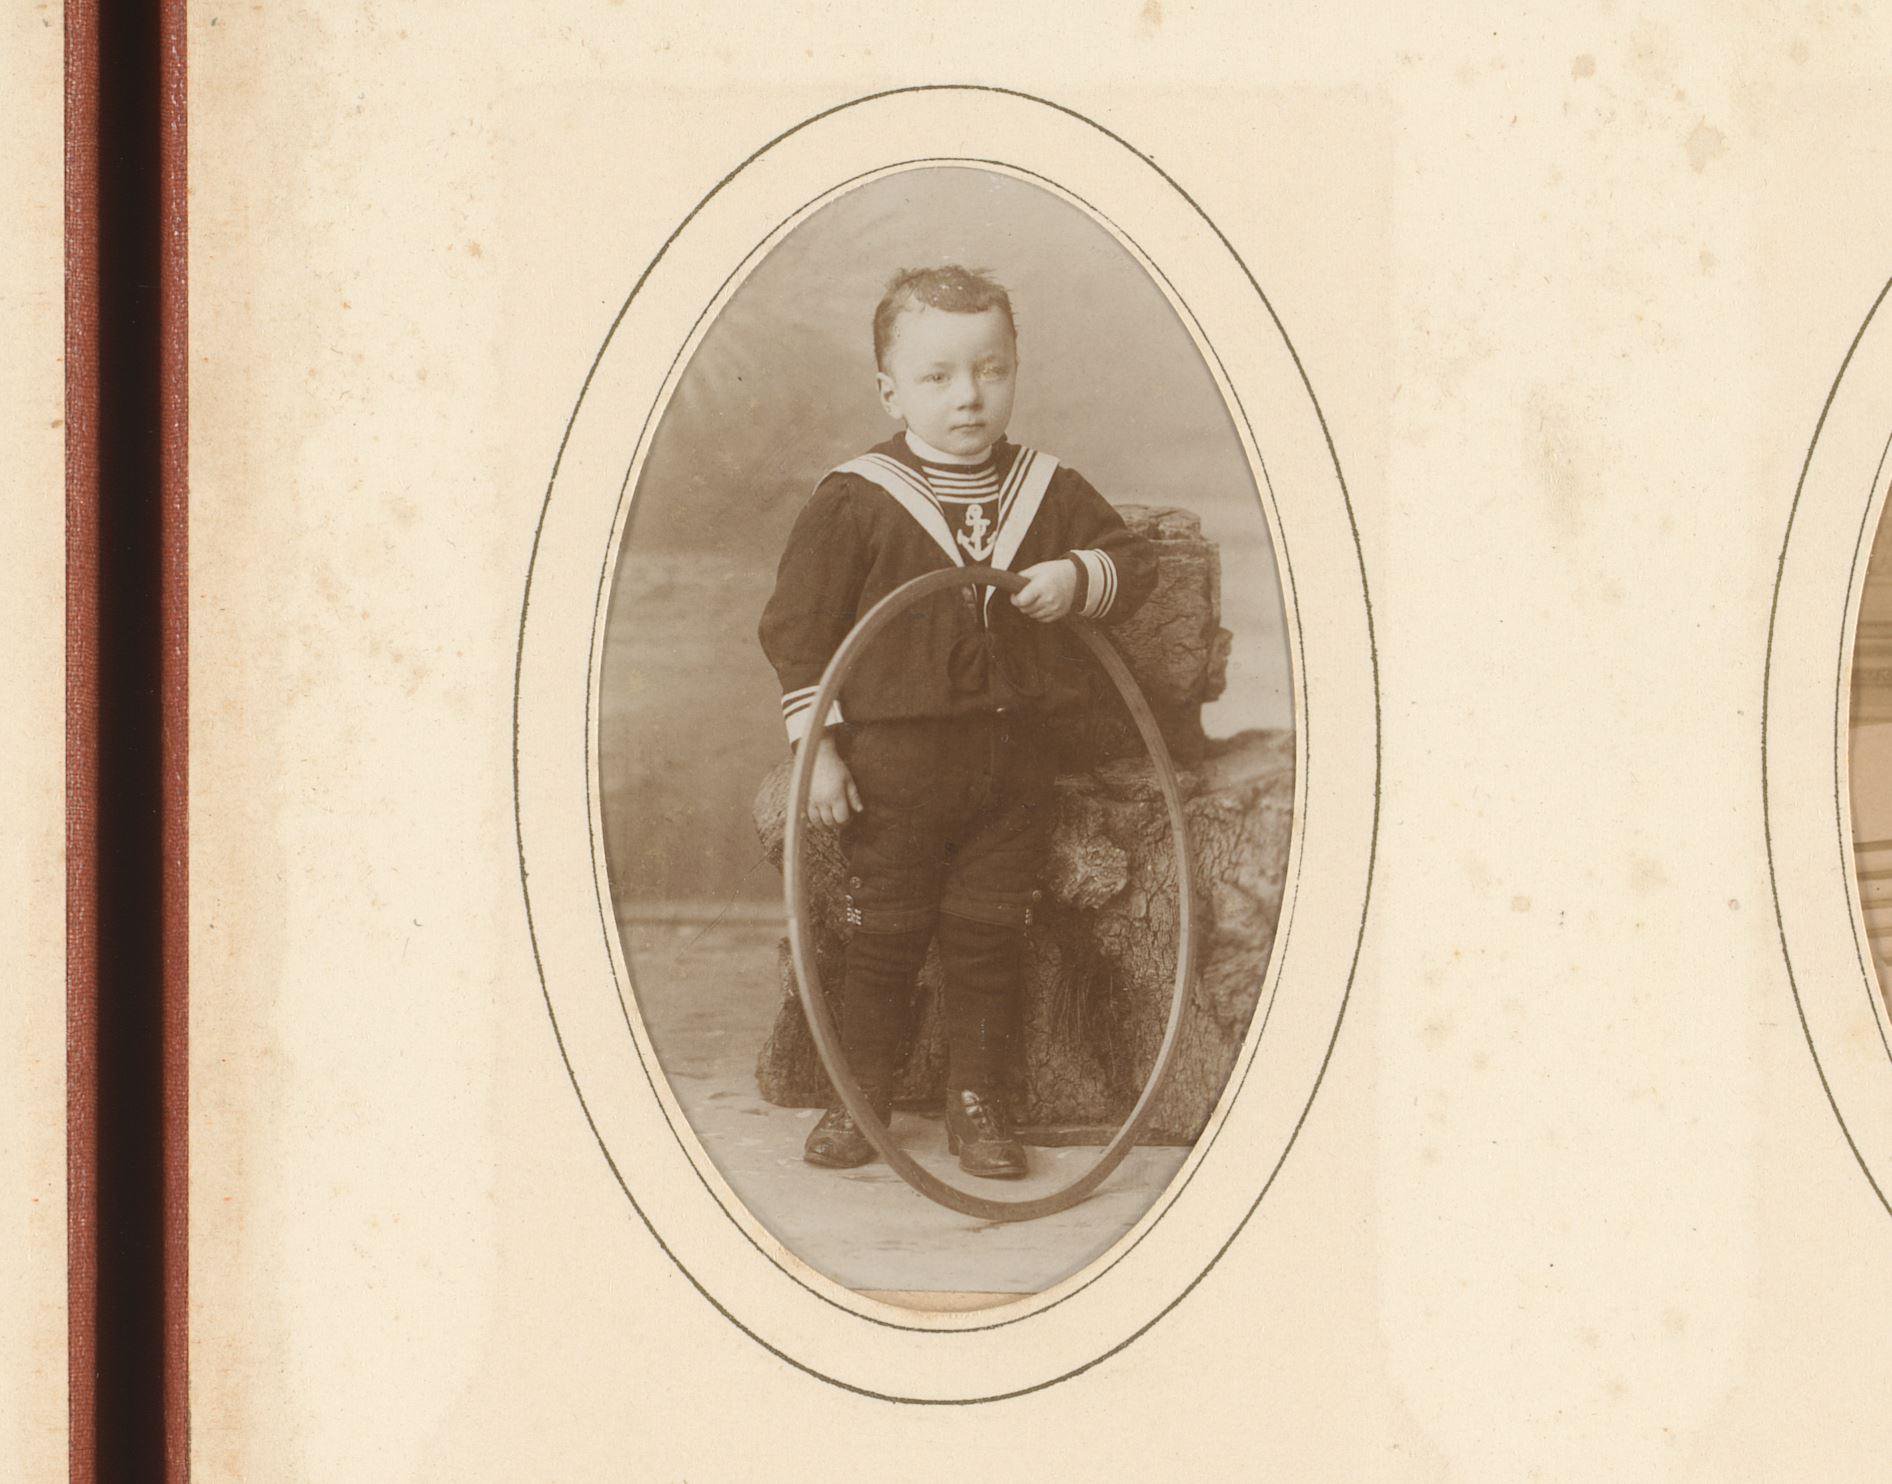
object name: carte de visite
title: Portret van een jongen in matrozenpak met hoepel in de hand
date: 1880-1887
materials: cardboard, photographic support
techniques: collodion silver print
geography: amsterdam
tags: ensemble of pieces of clothing: sailor suit, historical persons, toddler (male), (bowling a) hoop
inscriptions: inscription: ‘(...)/ Herz/ Photographisch Atelier/ Heerengracht 80 en Heerenstraat 4/ AMSTERDAM/ No. 1340/ De plaat blijft ter nabestelling een/ jaar bewaard./ Specialiteit in vergrootingen/ Opnamen van stadsgezichten,/ landschappen en schilderijen in alle/ formaten en ook voor stereoscoop.’